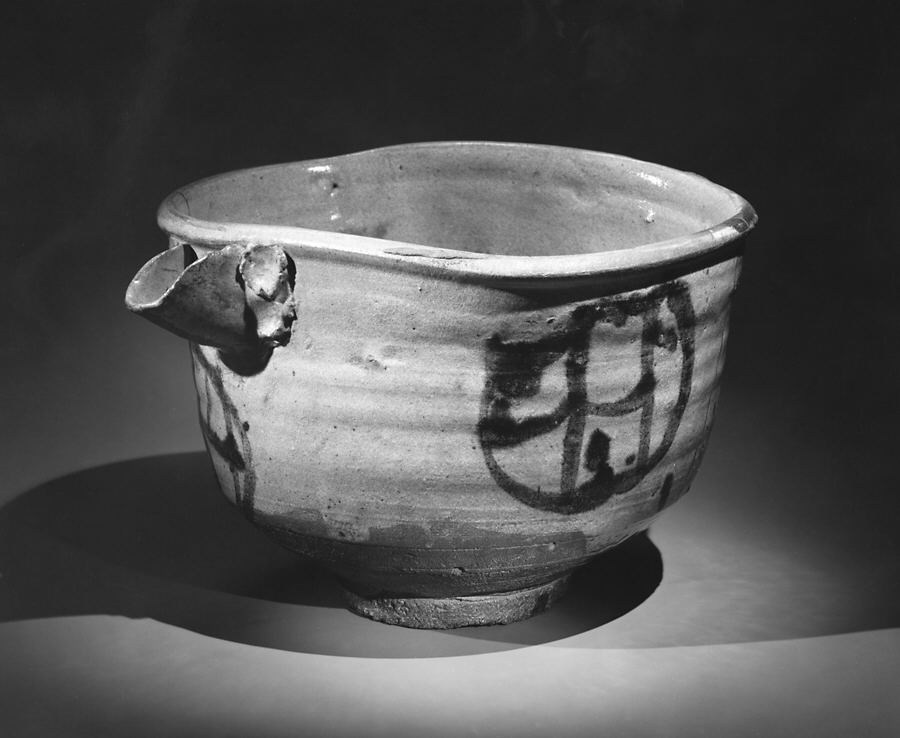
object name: pouring vessel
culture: japanese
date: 1601-1633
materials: iron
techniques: painting, underglaze